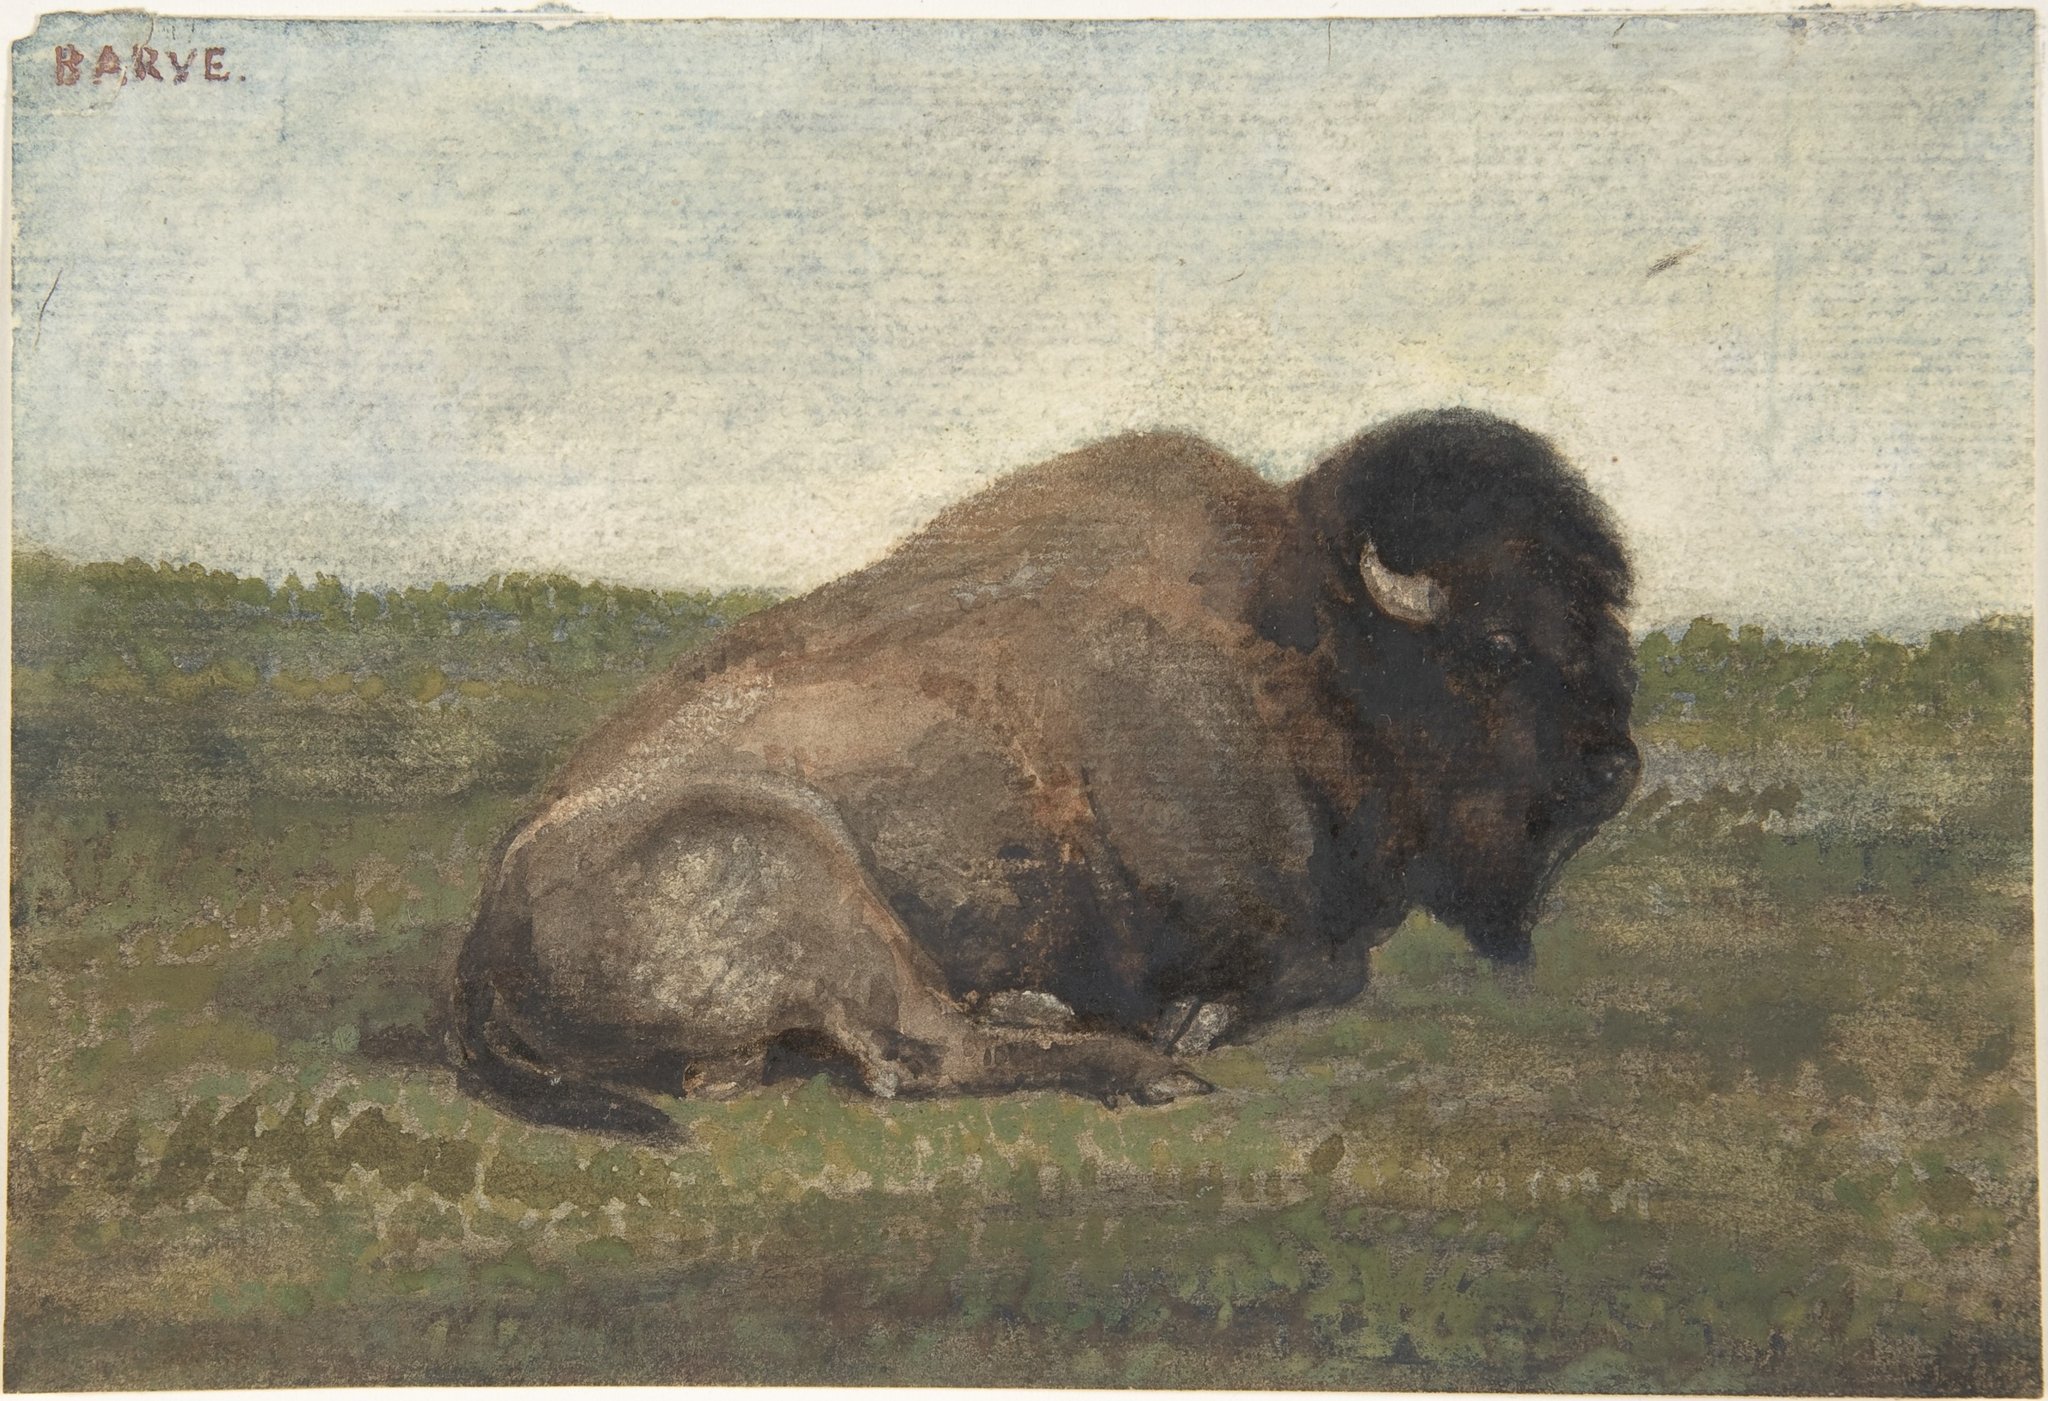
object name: drawing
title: Bison Lying Down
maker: antoine-louis barye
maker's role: artist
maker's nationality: french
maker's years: 1795-1875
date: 1810-1875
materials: paper, watercolor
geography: france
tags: animals